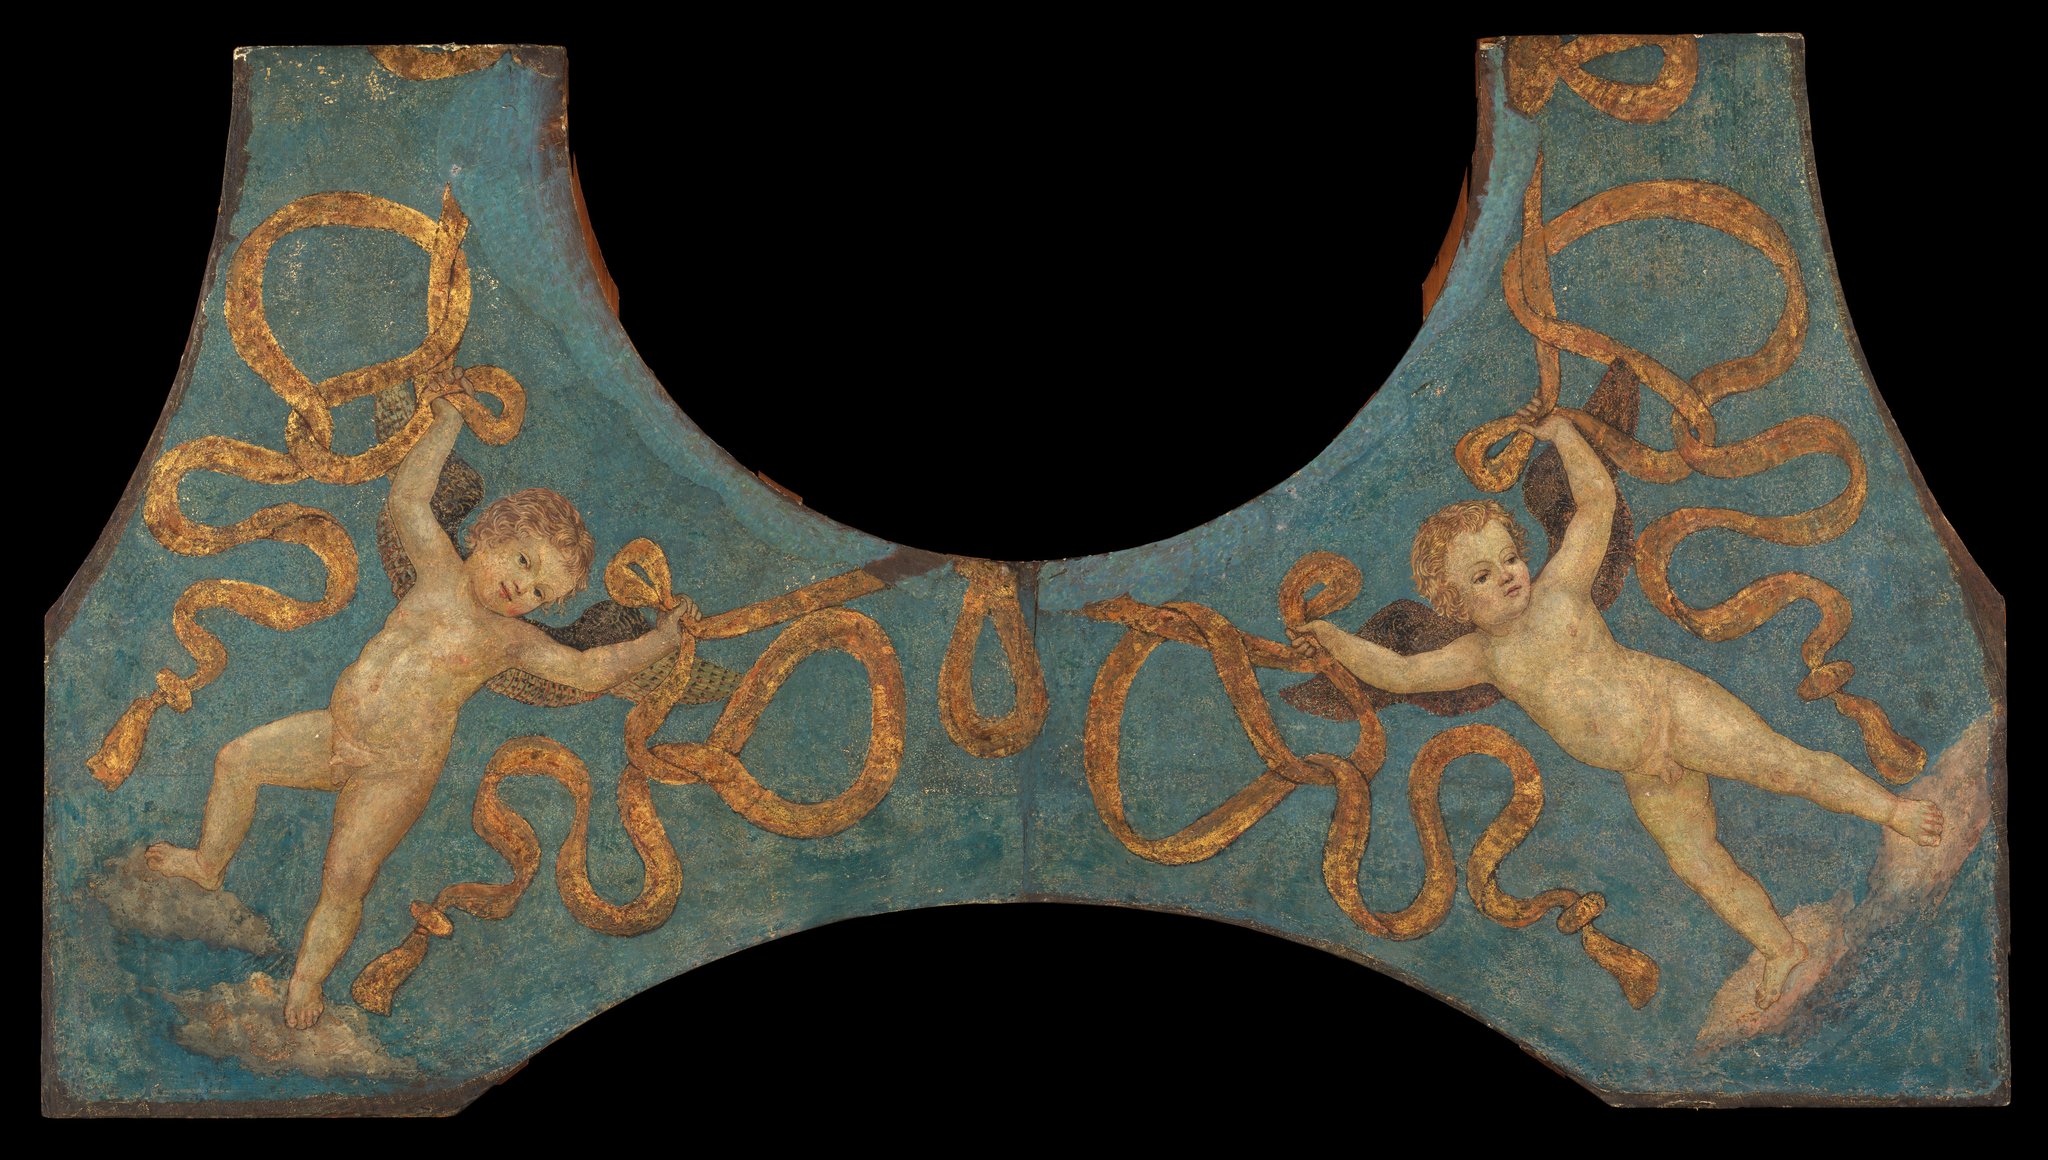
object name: ceiling panel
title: Putto with garlands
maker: pinturicchio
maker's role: artist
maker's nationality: italian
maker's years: 1454-1513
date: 1509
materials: canvas, panel, wood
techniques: fresco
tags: garlands,putti